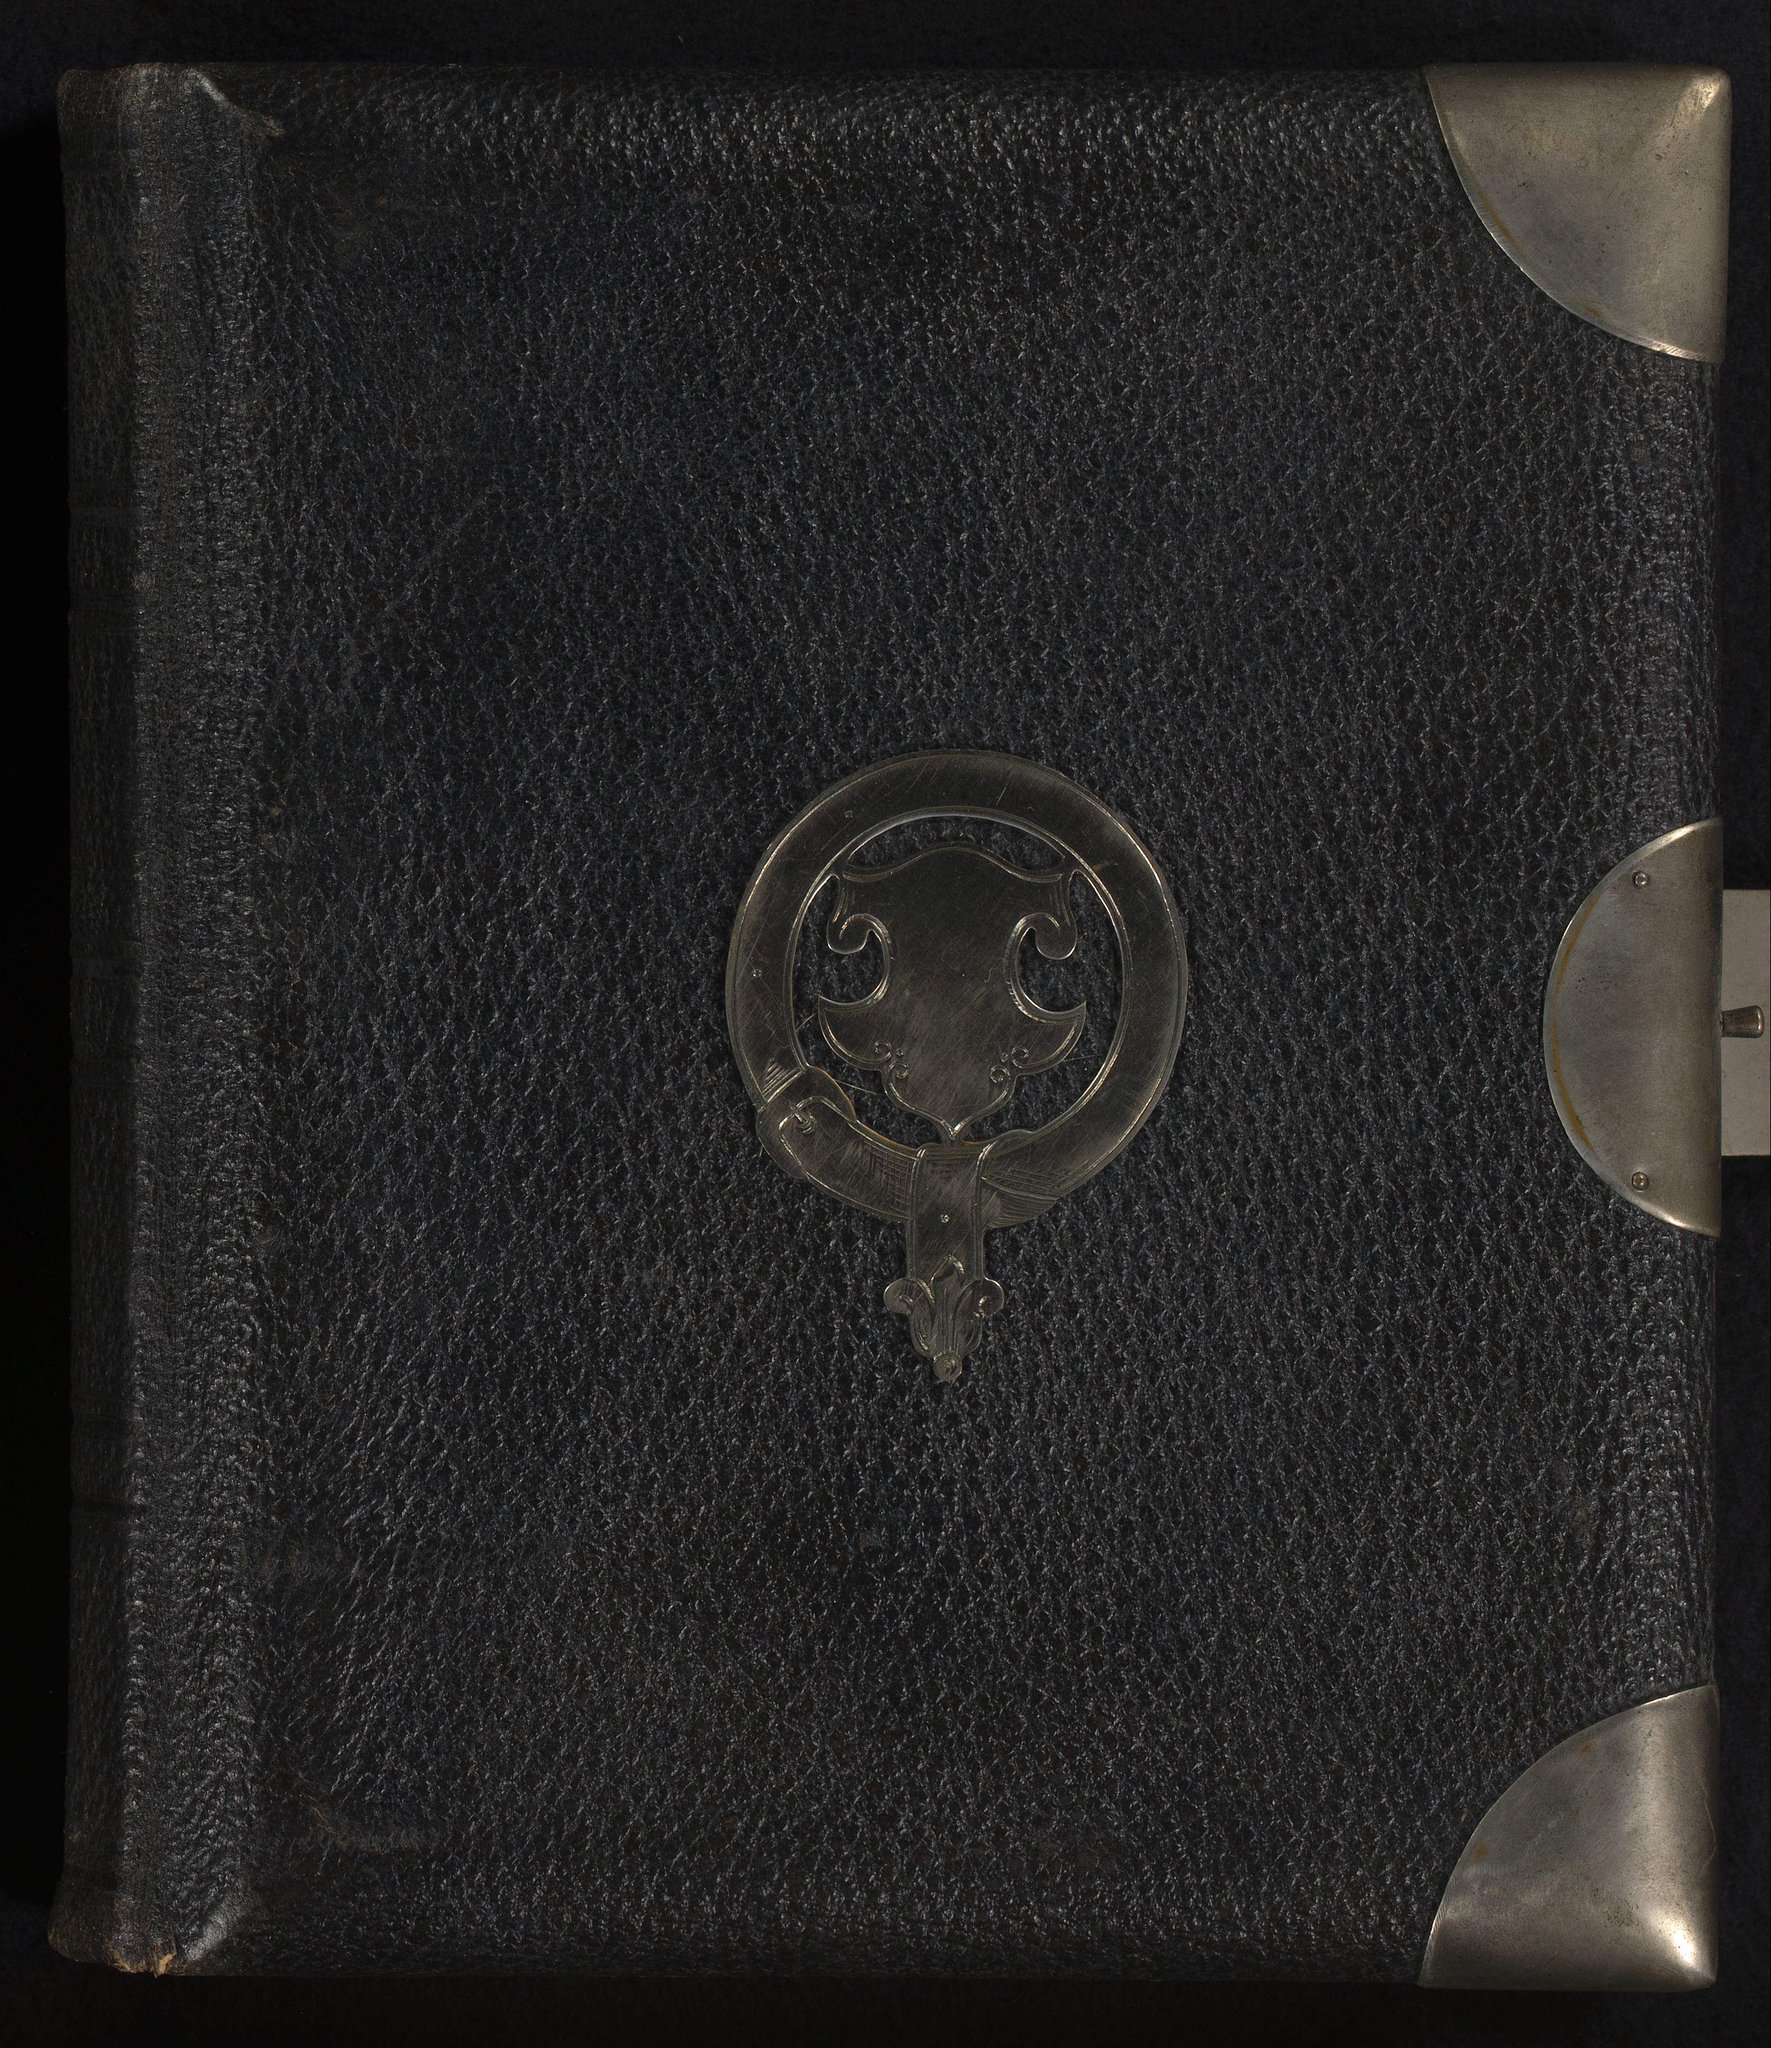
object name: slip in album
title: Fotoalbum (leeg)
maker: Anonymous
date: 1860-1900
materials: cardboard, leather, metal, paper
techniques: color on snow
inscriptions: collector's mark: ‘DIENST/ VERSPREIDE/ RIJKSKOLLEKTIES/ (...) A 837’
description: Fotoalbum met veertig pagina's met ieder een met gouden lijnen omkaderde passe-partout voor een kabinetfoto.